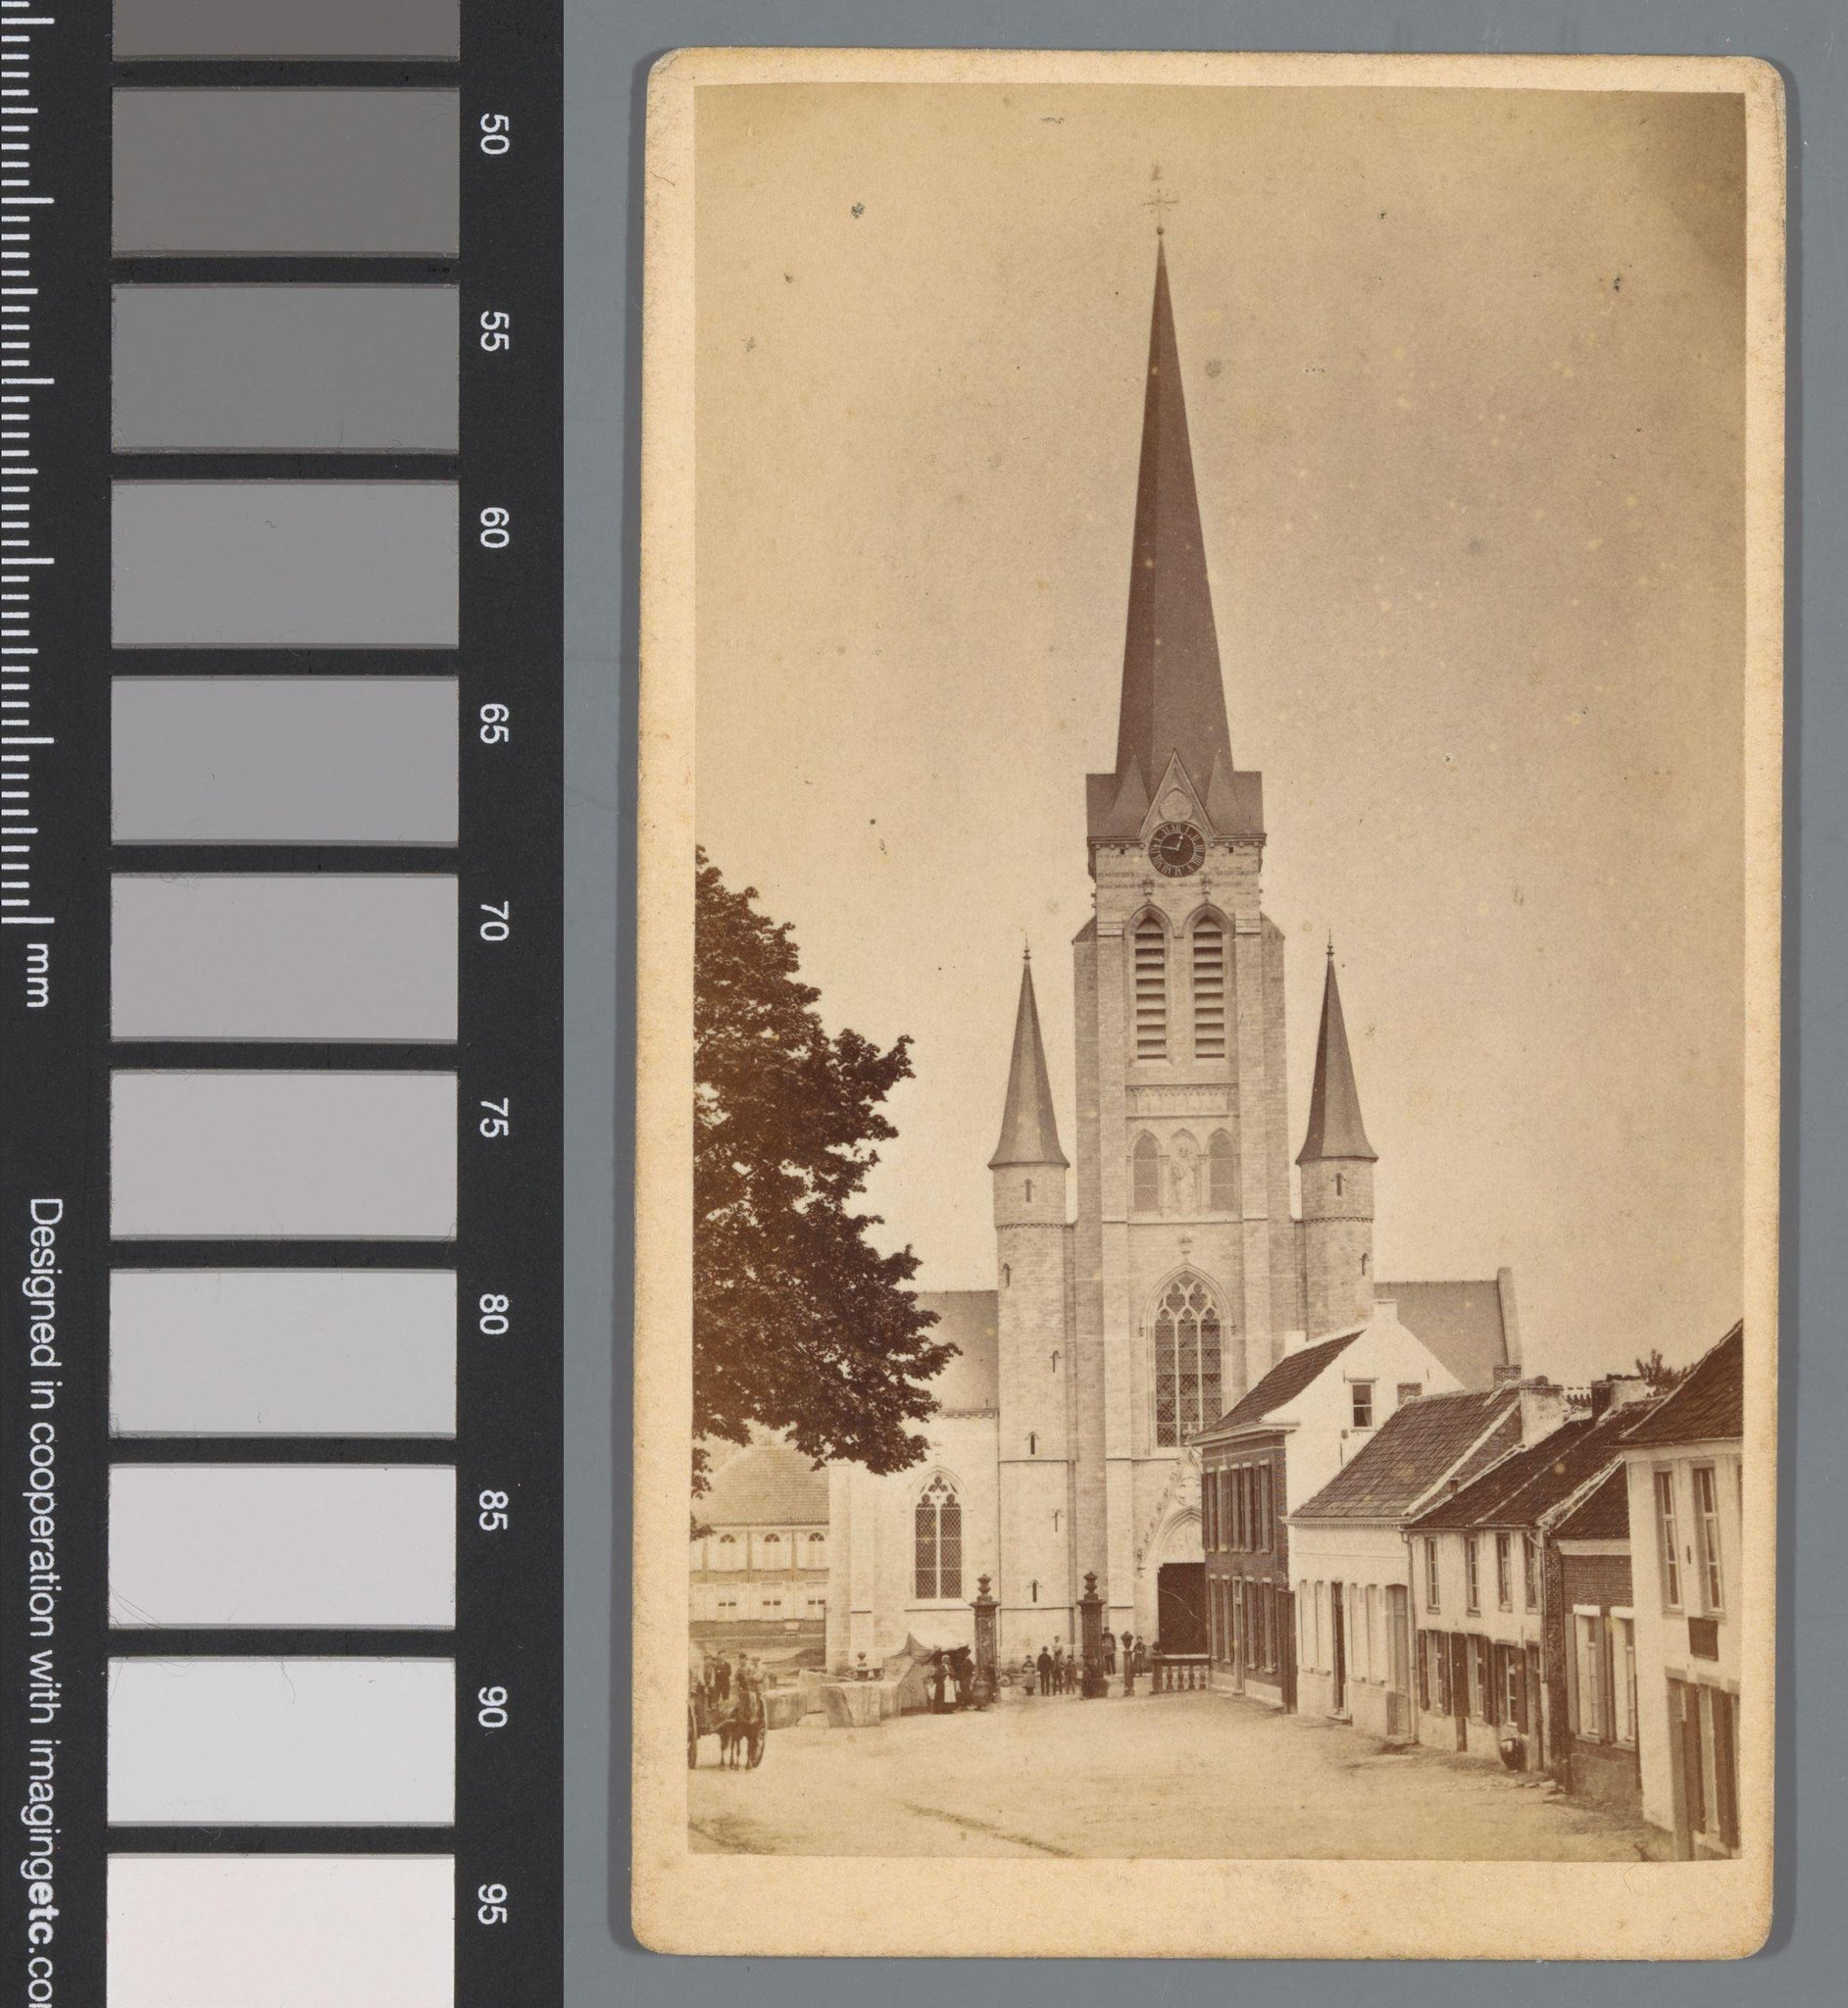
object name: carte de visite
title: Neogotische kerktoren, vermoedelijk in België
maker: august rombaut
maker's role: fotograaf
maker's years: 1834-1892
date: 1867-1871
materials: cardboard, paper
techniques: albumen print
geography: sint-niklaas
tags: church (exterior)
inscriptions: address: ‘St. Nikolaas, Nieuwstraat 60.’